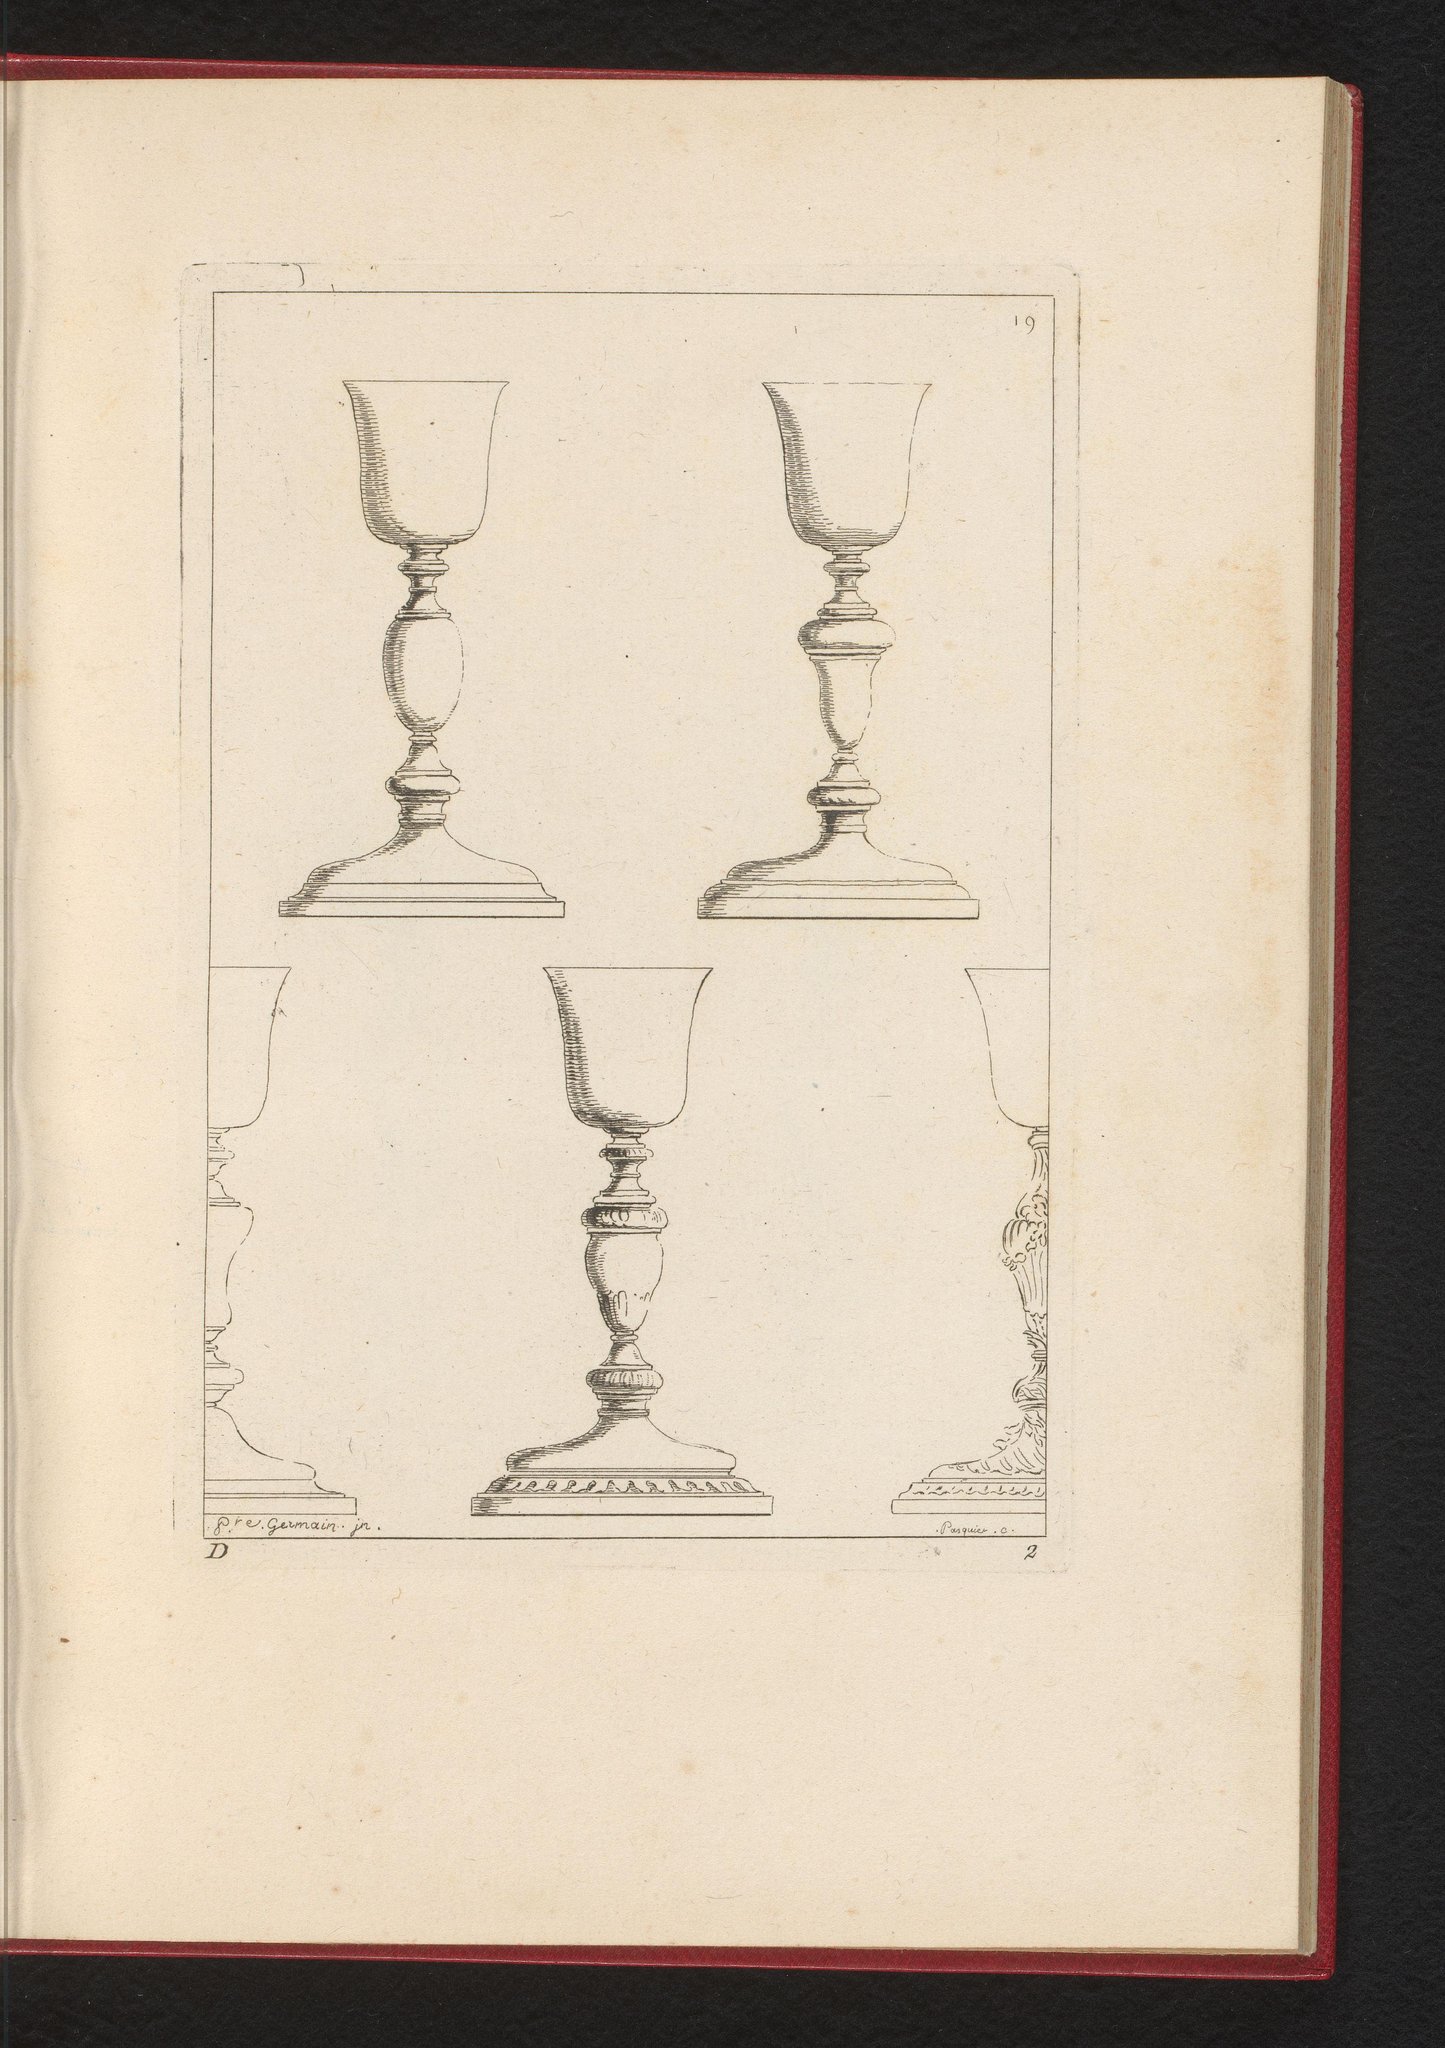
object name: album leaf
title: Zilverwerk en edelsmeedkunst, eerste deel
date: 1748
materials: paper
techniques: etching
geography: paris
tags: chalice, jeweller, goldsmith, silversmith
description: Een aantal van de objecten in deze reeks heeft een eigen ondertitel, die verwijst naar genummerde 'cahiers' (afleveringen) waarin de prenten werden uitgegeven. Het is onduidelijk welke objecten recies bij welke aflevering horen. Daarom is die ondertitel enkel verwerkt bij de prent waarop die voorkomt.